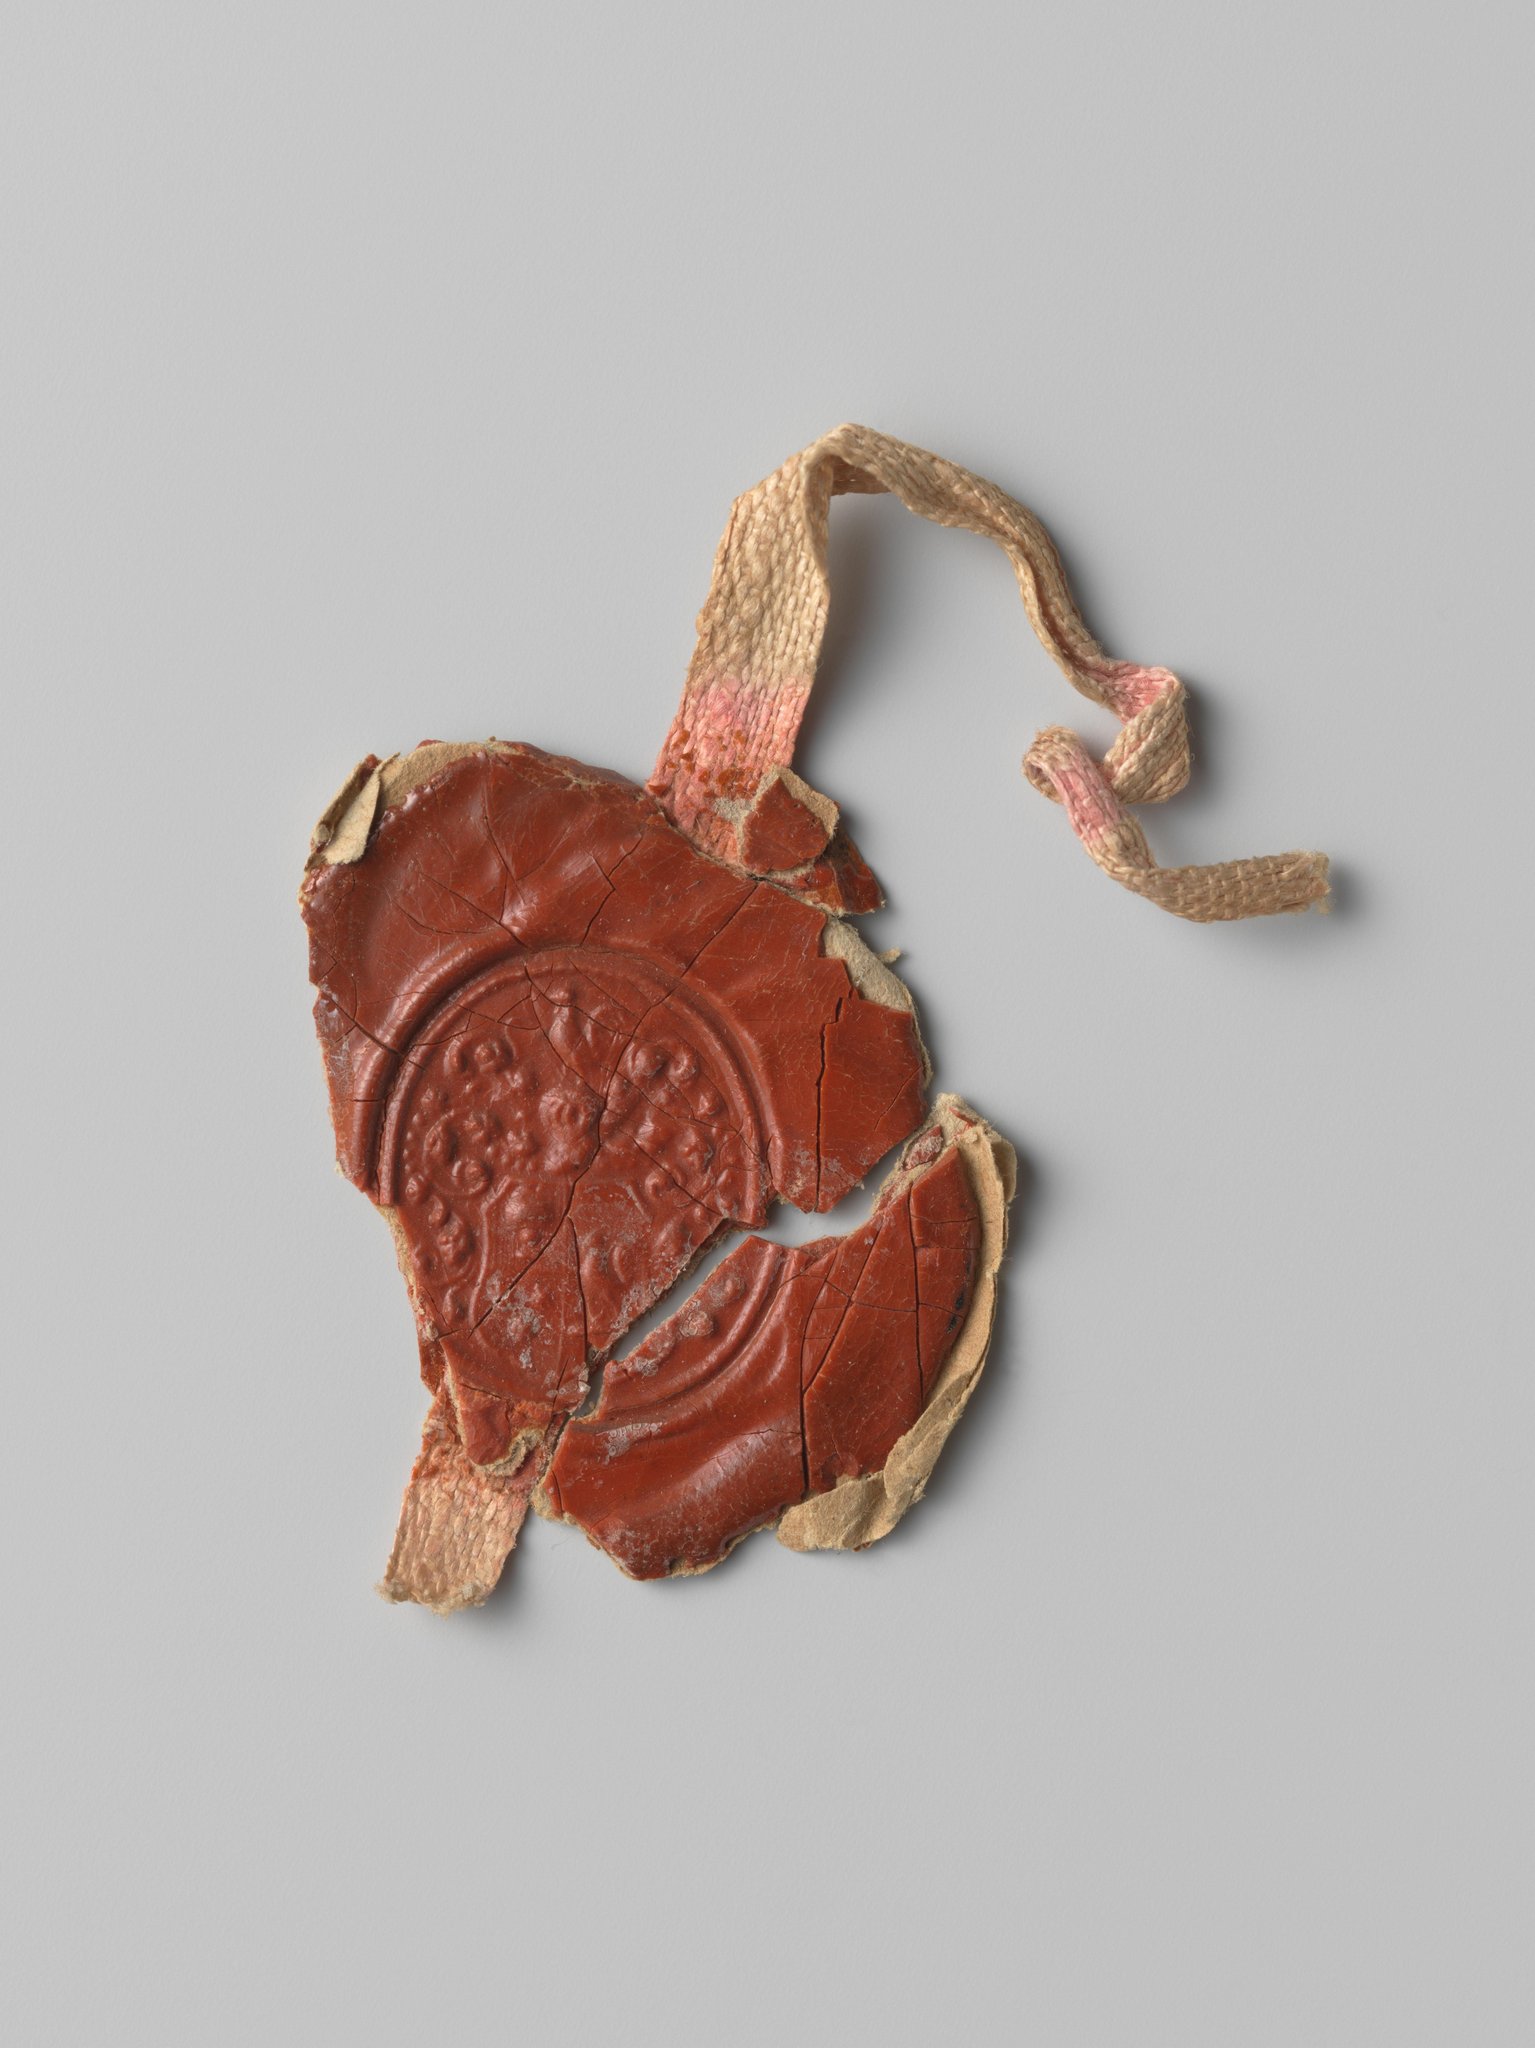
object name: lakzegel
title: Lakzegel ( mogelijk van generaal Chassé)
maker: Anonymous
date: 1830-1832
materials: lacquer, linen, paper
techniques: printing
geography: netherlands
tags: david hendrik baron chassé, netherlands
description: Een zegel van rode lak op restant van papier. Tussen zegel en papier een plat wit lint. Het deels gebroken en incomplete zegel toont, in een dubbele ovale rand een wapenschild: linksboven een beker, rechtsonder drie (sterren?). Rechts: een naar links gaande (haan?). Het schild is bekroond door een helm met gesloten vizier, waarboven een naar links gekeerde (haan?) staat. Rondom het schild dekkleden. op de achterzijde van het zegel staat de tekst gener(aal?) Chassé?. Het zegel ligt in een wit doos met de tekst Roosdorp 4. Lakzegel bij sjerp baron D.H. Chassé.